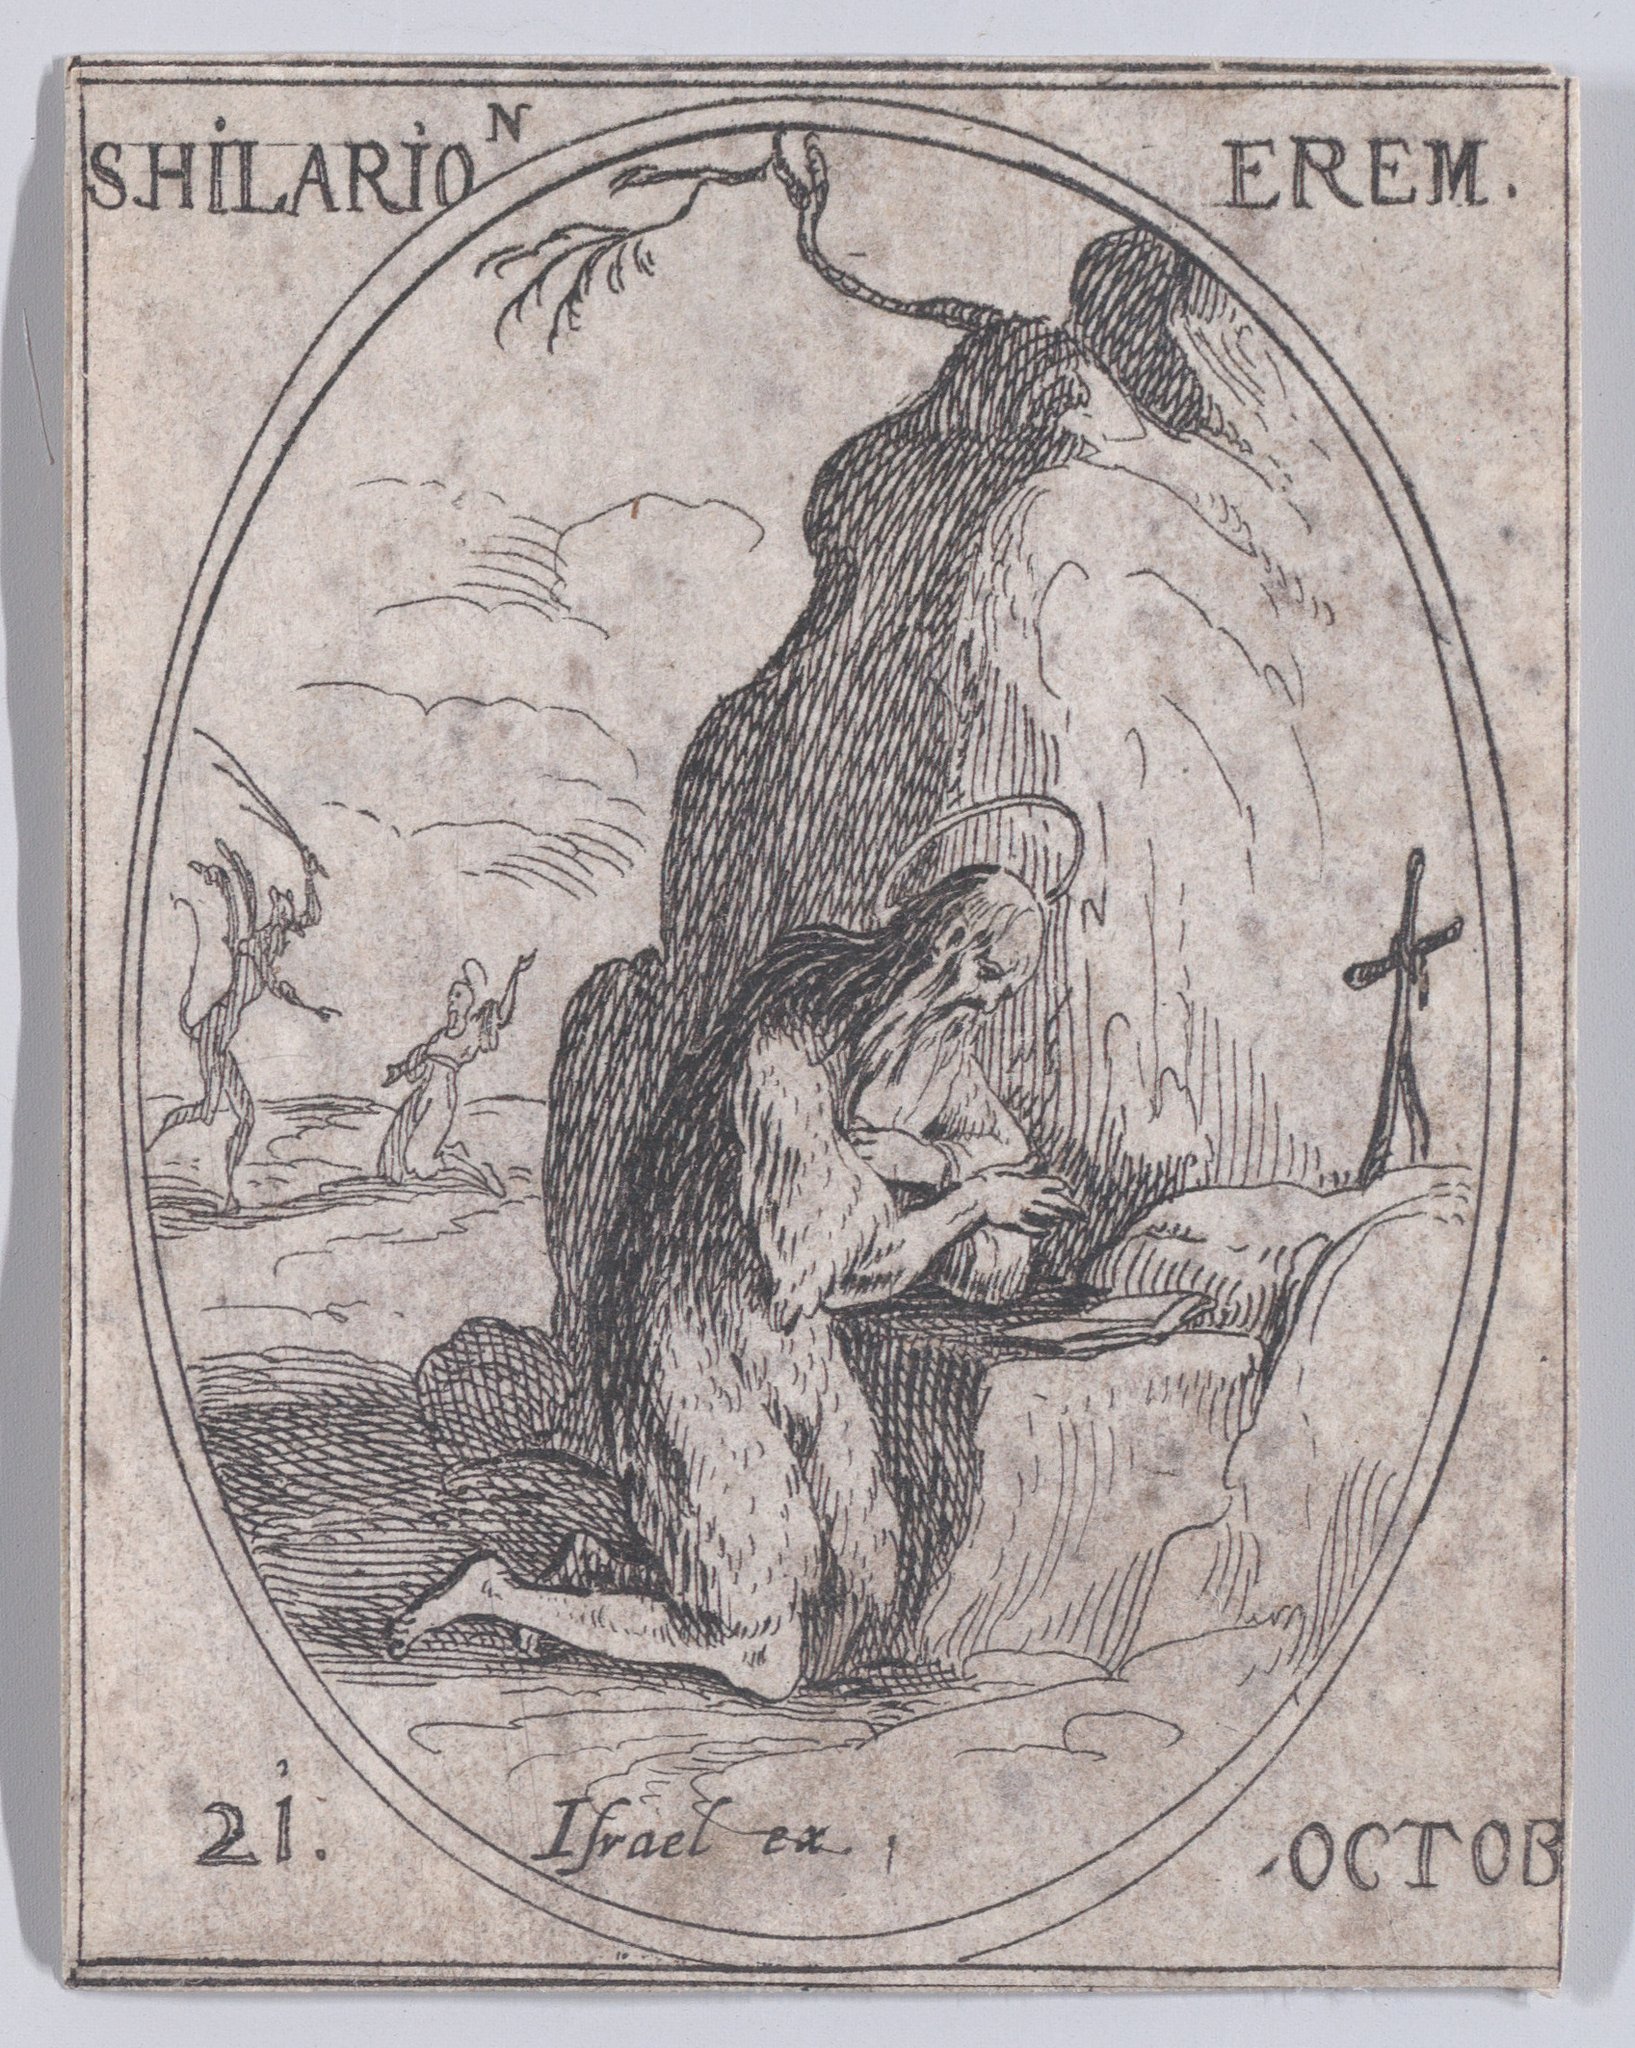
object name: print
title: S. Ilarion, ermite (St. Hilarion, Hermit), October 21st, from "Les Images De Tous Les Saincts et Saintes de L'Année" (Images of All of the Saints and Religious Events of the Year)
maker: jacques callot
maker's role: artist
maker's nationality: french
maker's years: 1592-1635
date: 1636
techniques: etching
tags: men,saints